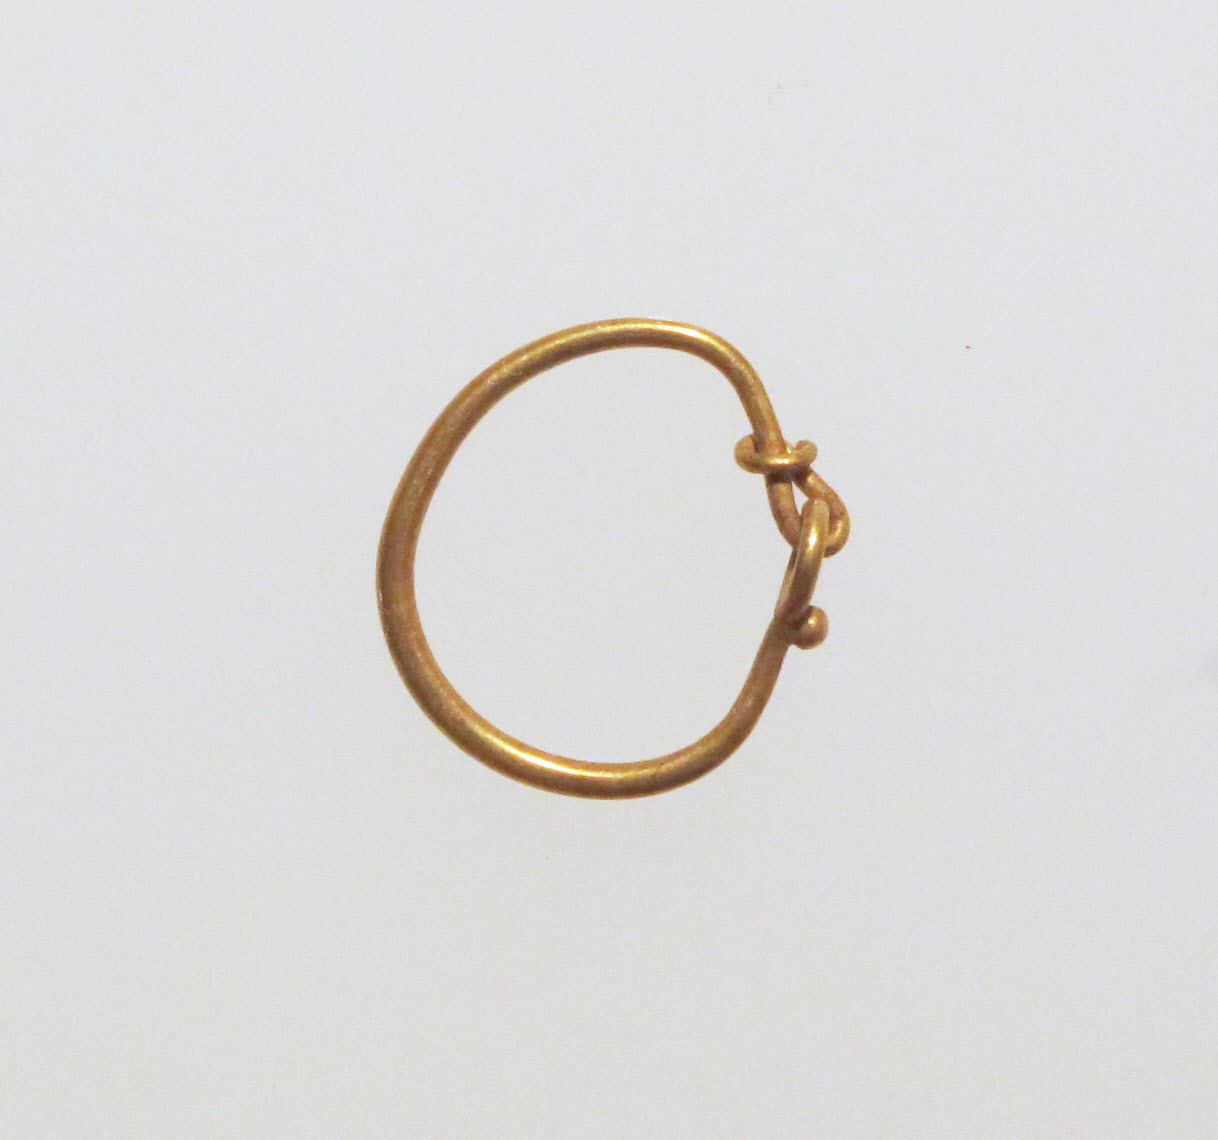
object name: earring loop type, plain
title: Earring-loop type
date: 7000 BCE-330 CE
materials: gold